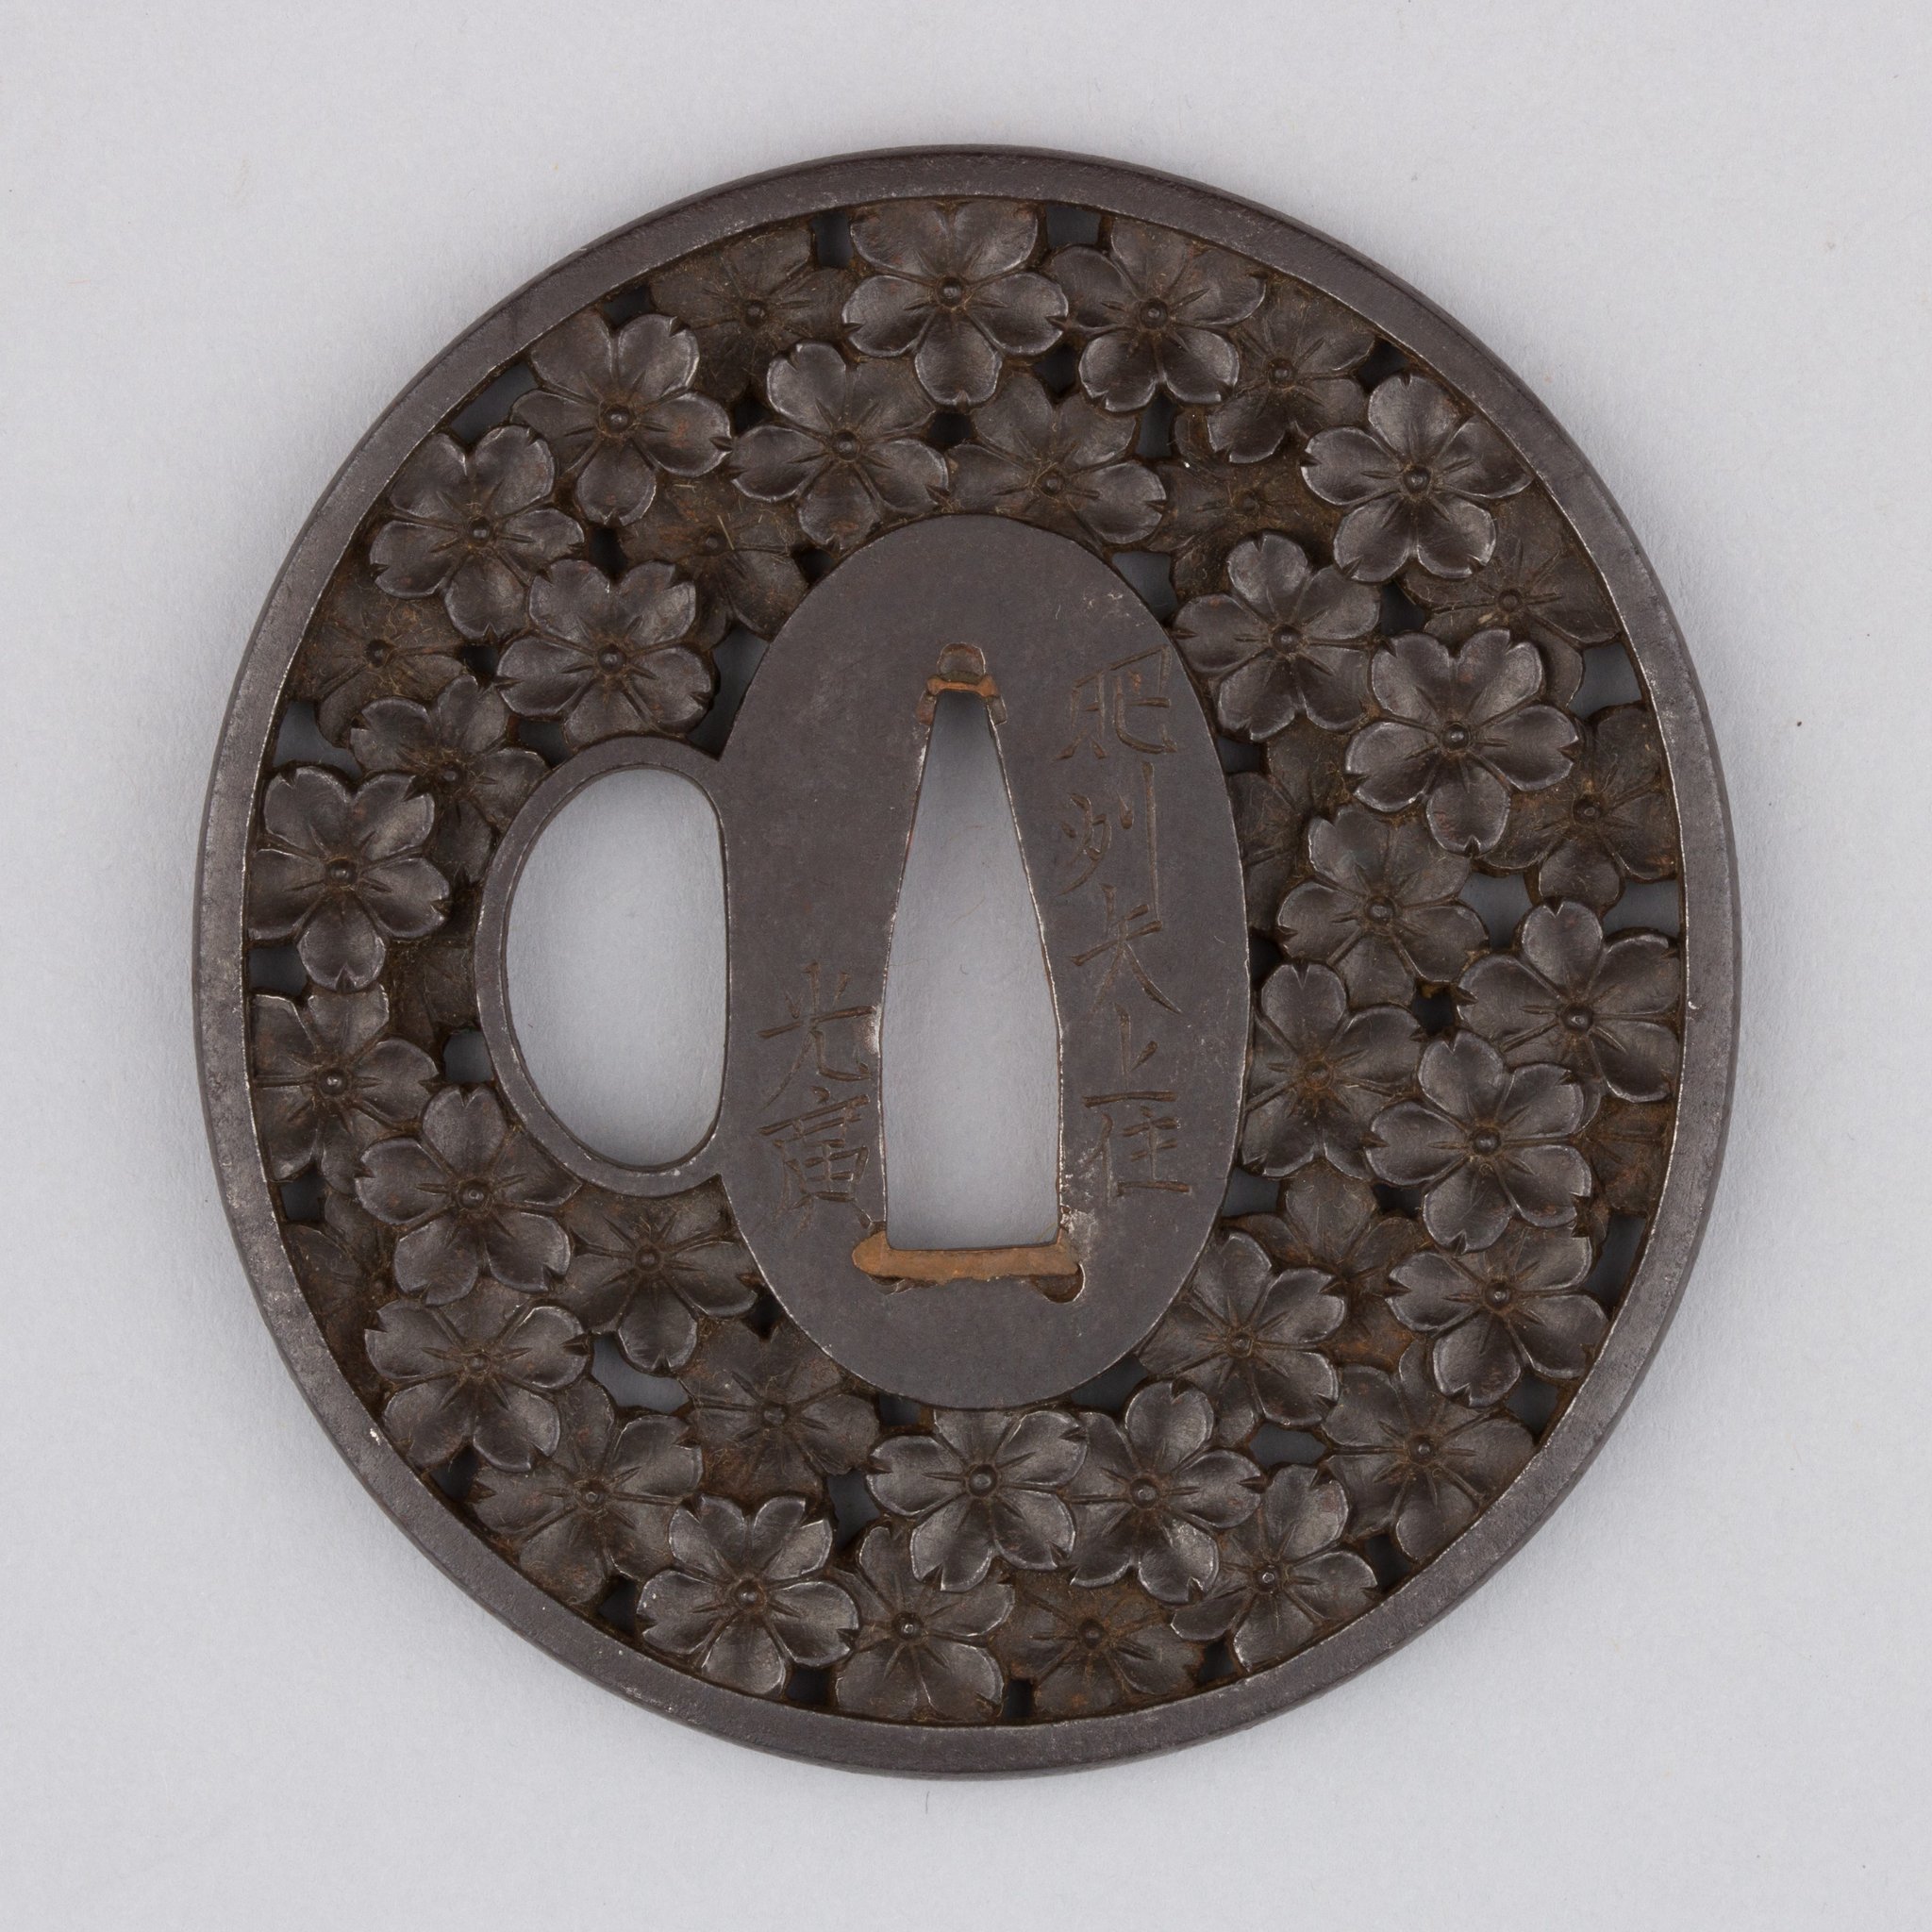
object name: sword guard tsuba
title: Sword Guard (Tsuba)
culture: japanese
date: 1767-1800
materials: copper, iron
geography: japan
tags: flowers